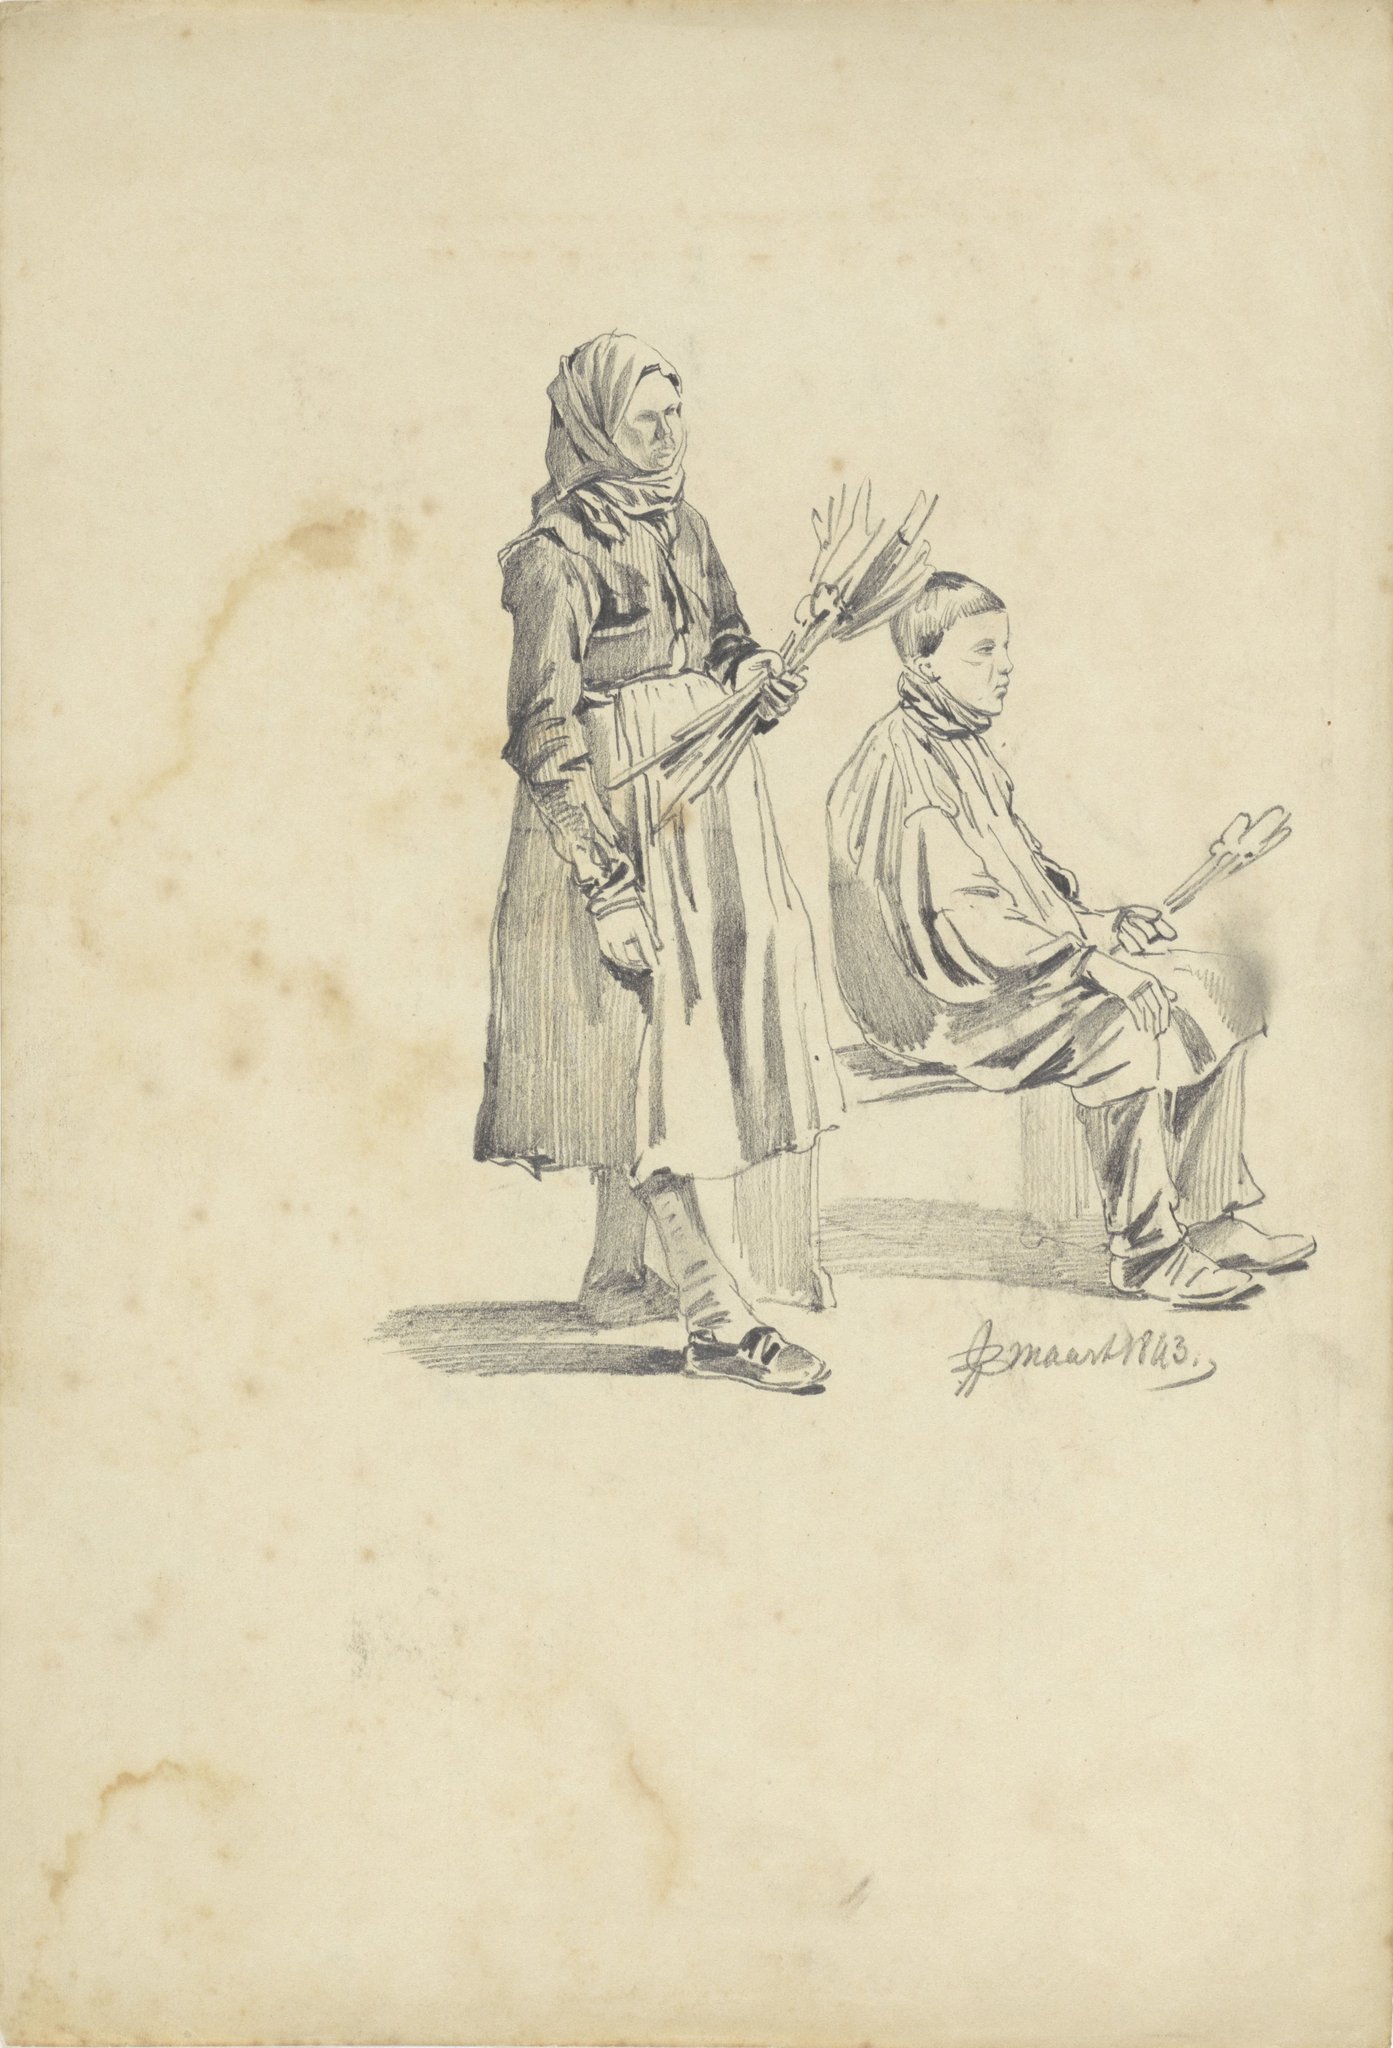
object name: drawing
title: Staande vrouw en zittende jongen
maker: pieter van loon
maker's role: draughtsman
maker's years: 1801-1873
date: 1803-1843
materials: paper, pencil